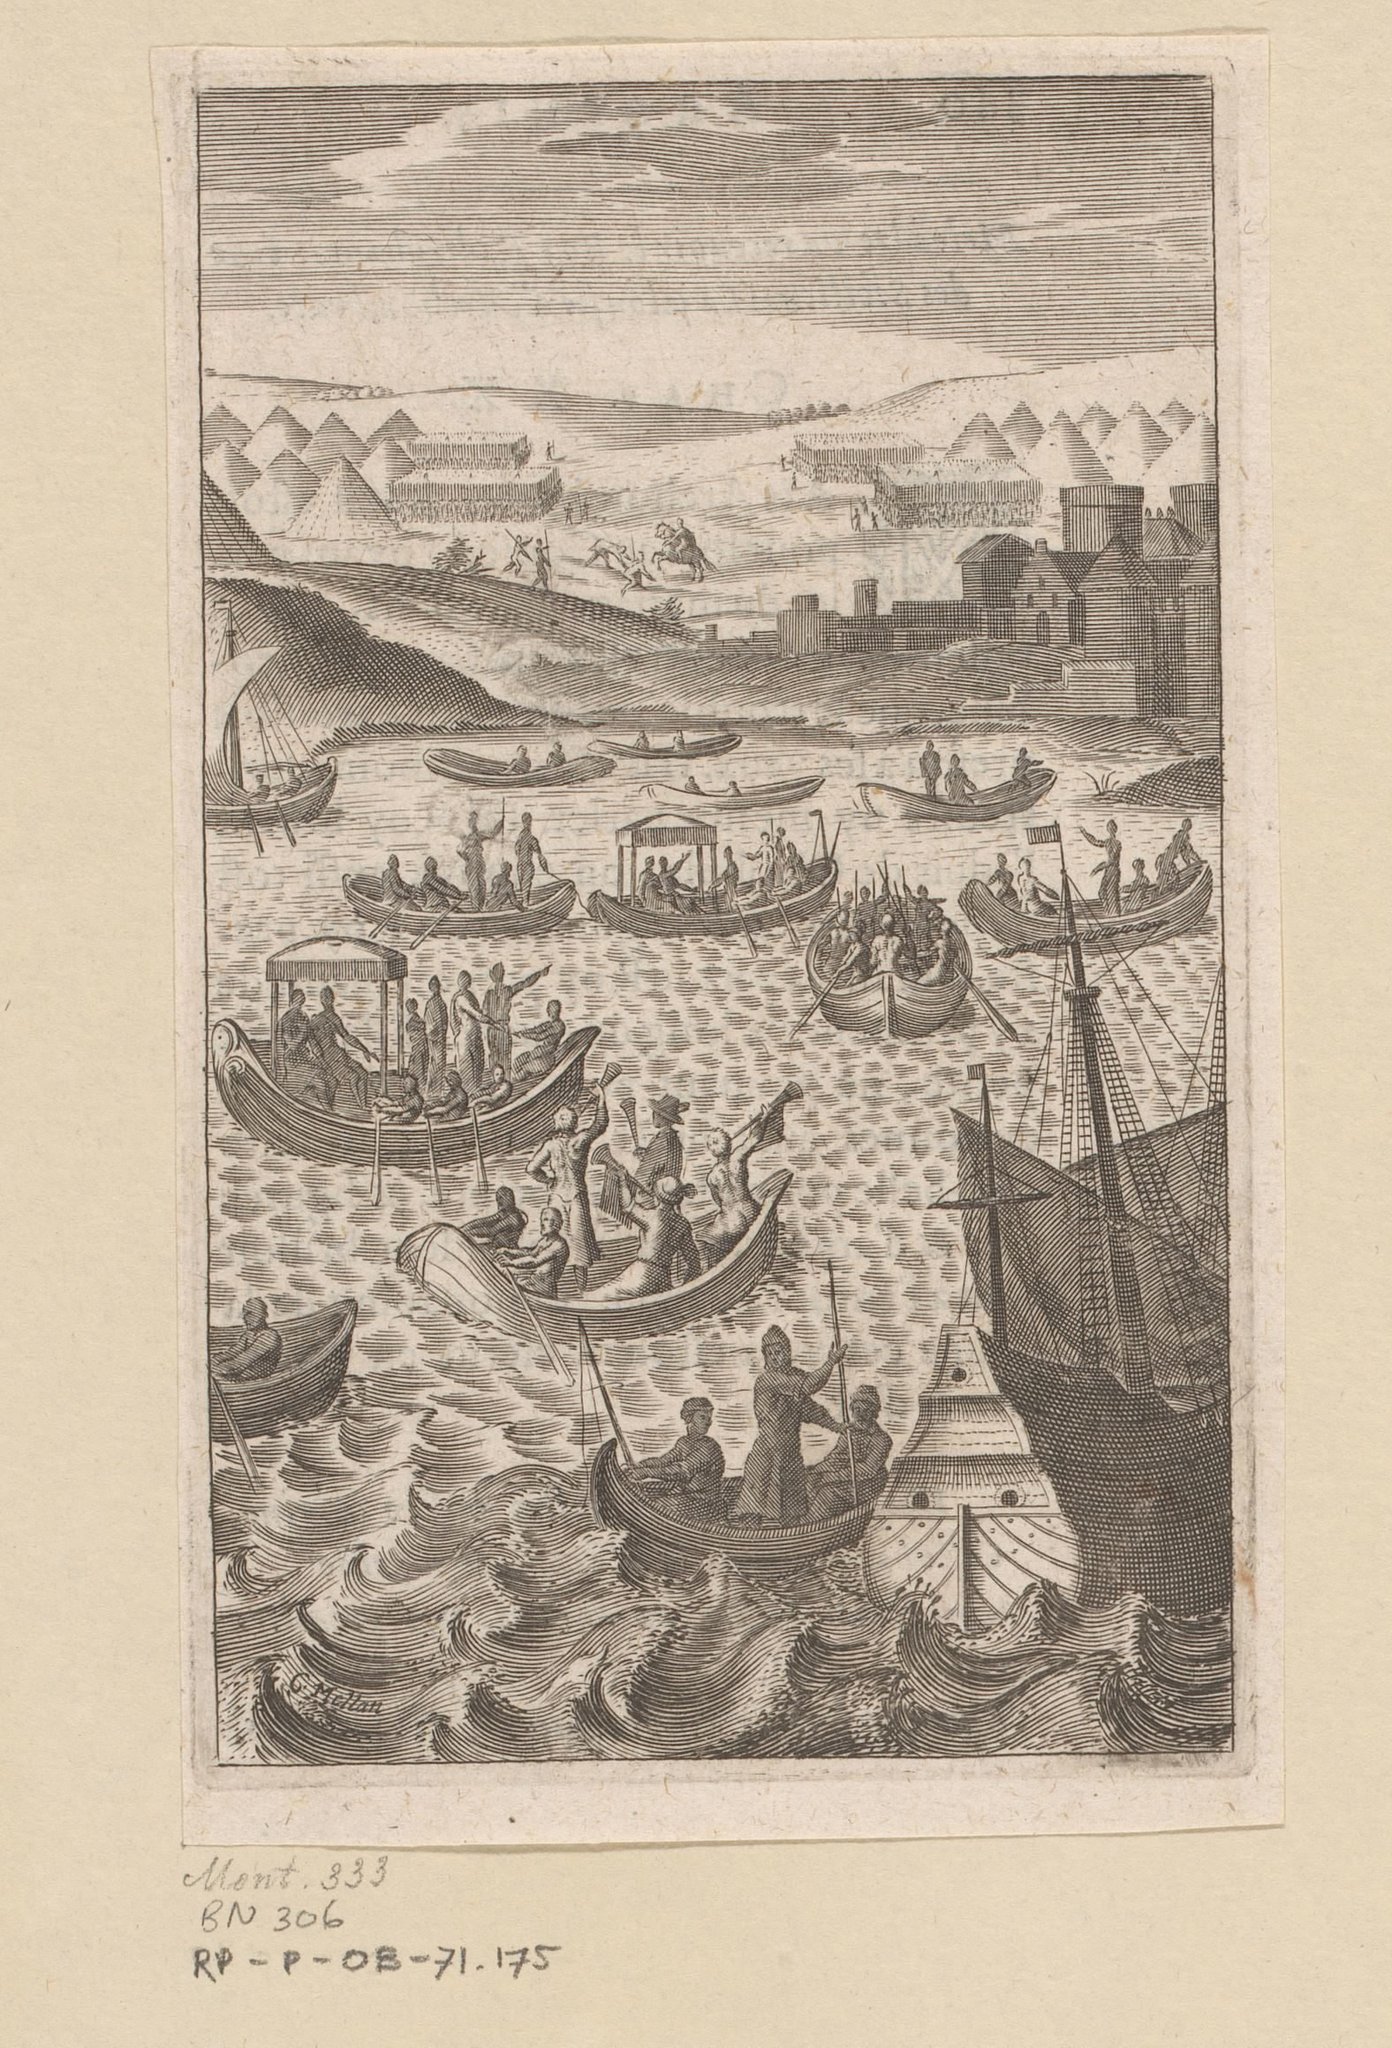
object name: book illustration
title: Vloot gondels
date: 1624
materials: paper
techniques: engraving, letterpress printing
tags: ships (in general), gondola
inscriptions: collector's mark: Lugt 240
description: Prent uit: Barclay, Jean. L'Argenis. Traduction nouvelle enrichie de figures. Parijs: Nicolas Buon, 1624, dl. 2, hoofdstuk 20. In 1625 werd een tweede editie uitgegeven, eveneens door Nicolas Buon en in 1636 werd een Engelse vertaling uitgegeven door Henry Seile in Londen.